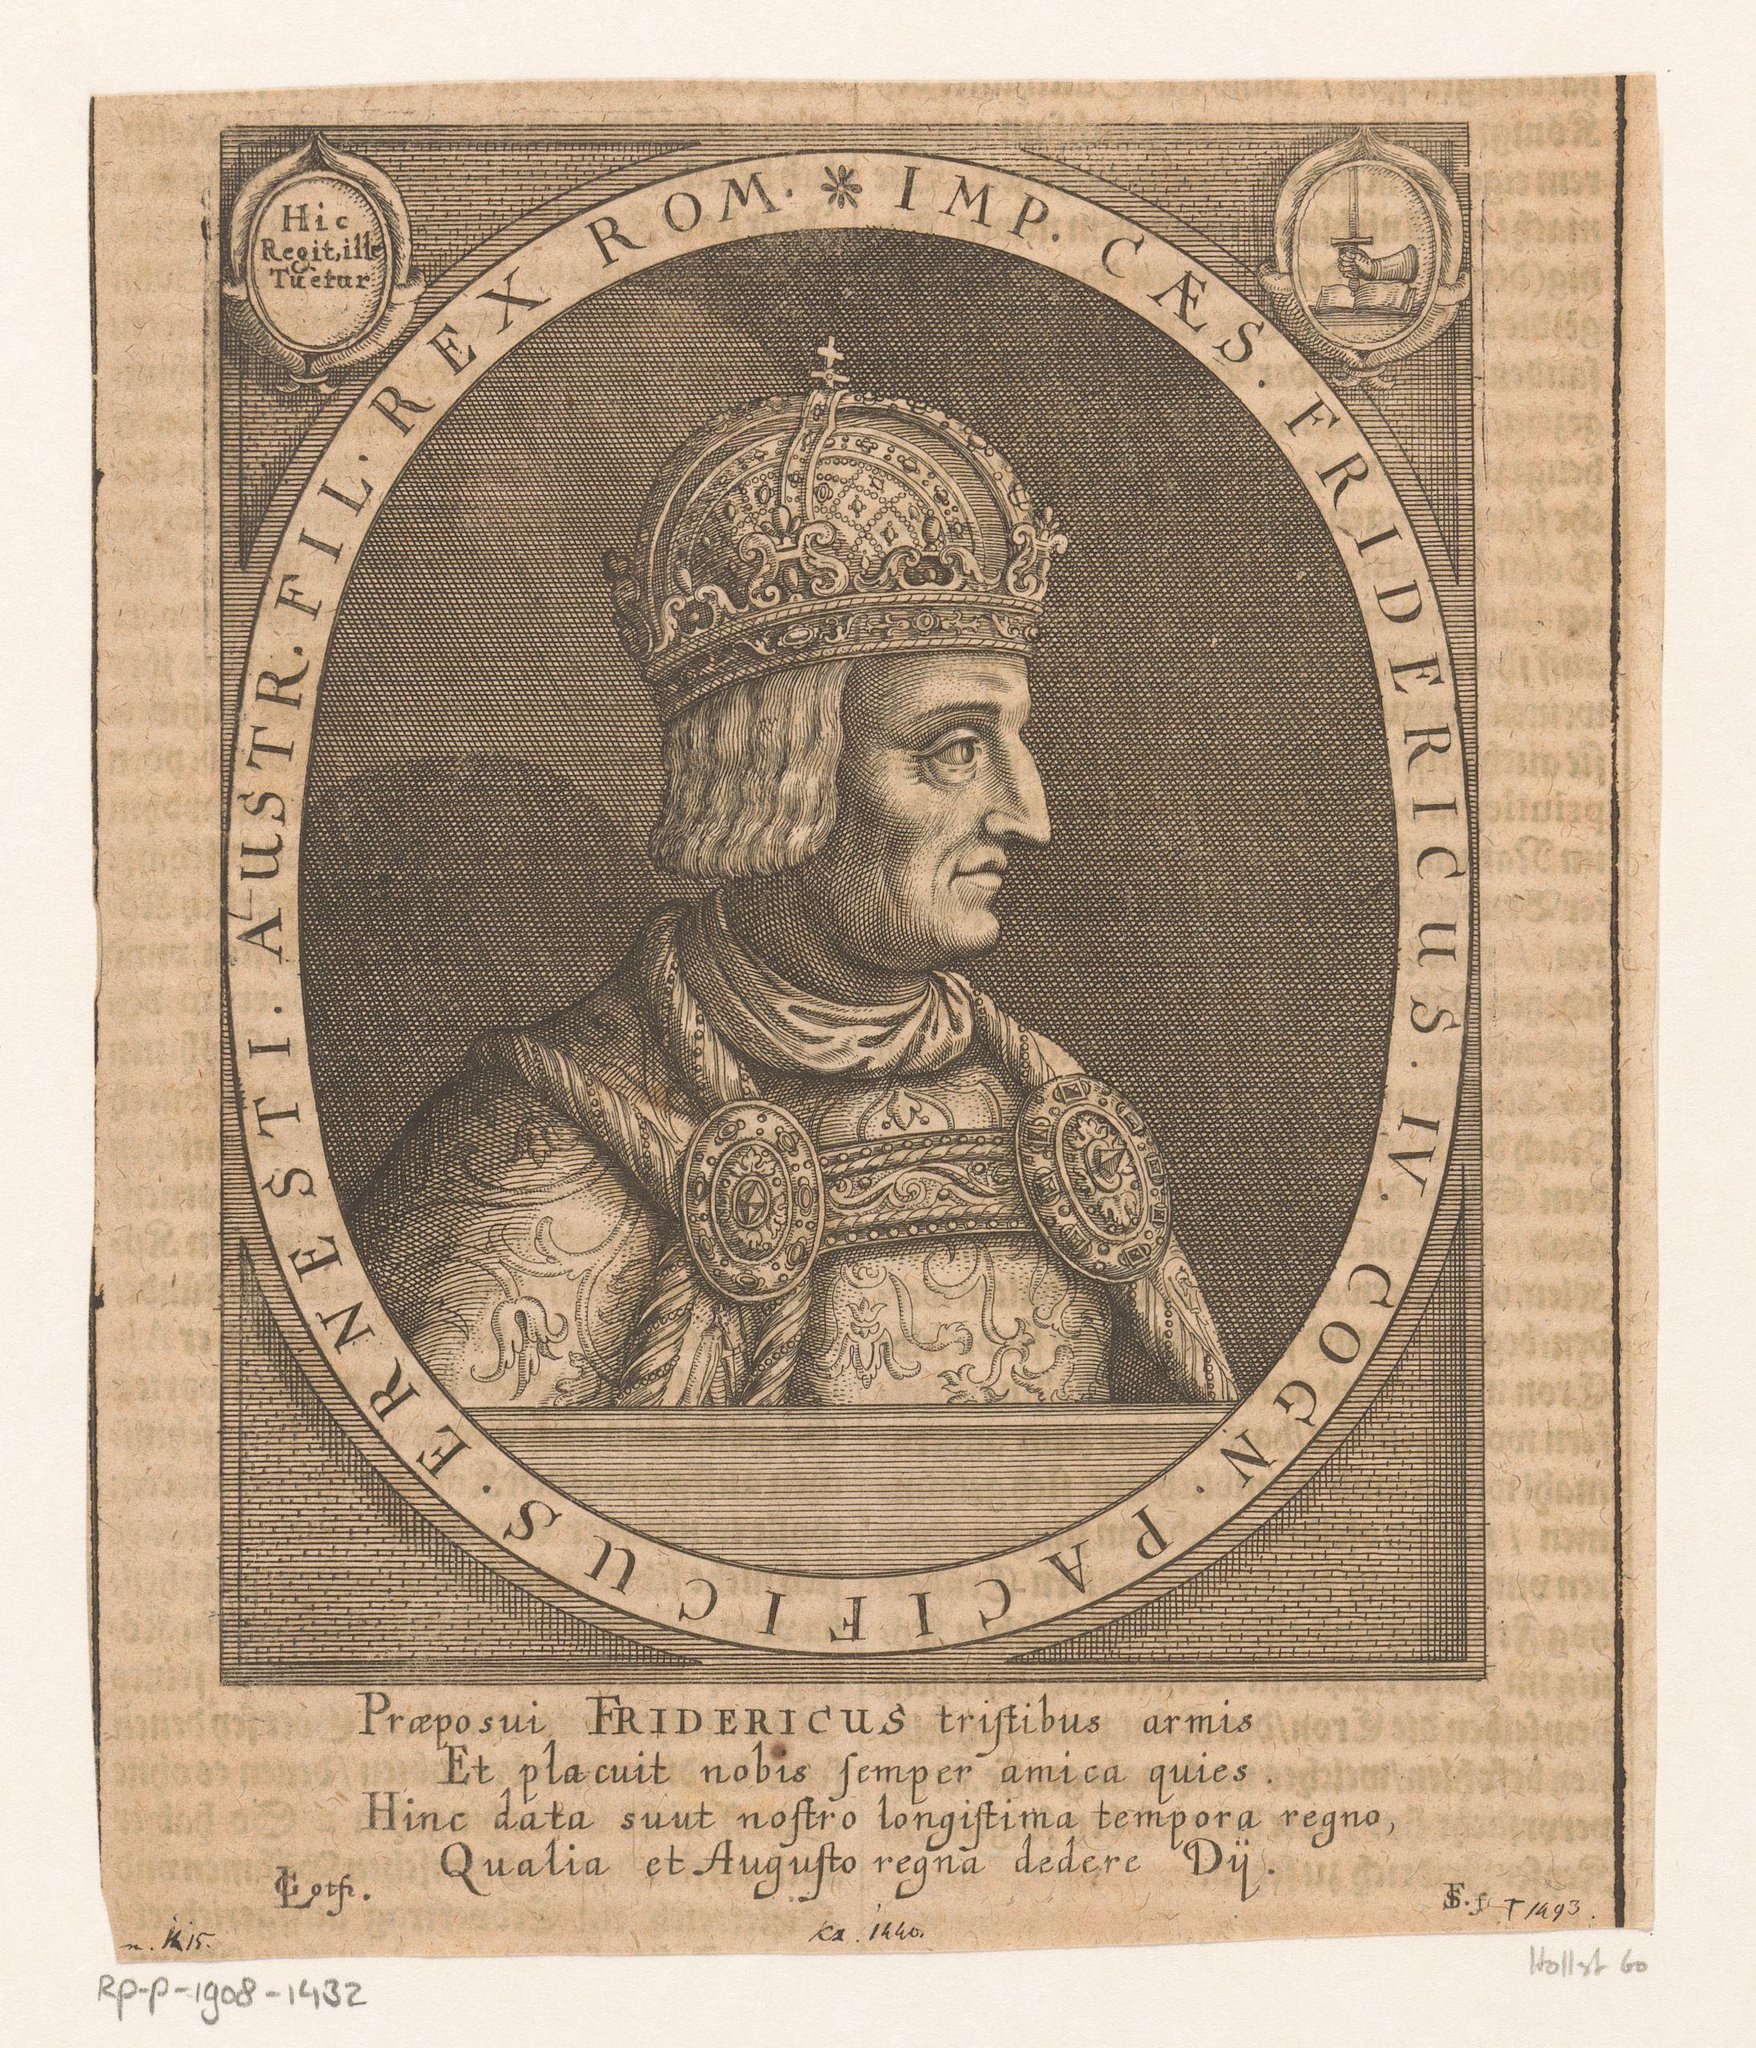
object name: book illustration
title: Portret van Frederik III van Habsburg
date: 1641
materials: paper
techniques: engraving, letterpress printing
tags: historical persons, emperor, abstract ideas and concepts (+ emblematical representation of concept)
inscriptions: collector's mark: Lugt 2228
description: Prent uit: Helvicus, Nicolaus. Theatrum Historiae universalis Catholico Protestantium (...). Frankfurt am Main: Johann Gottfried Schönwetter, 1641.